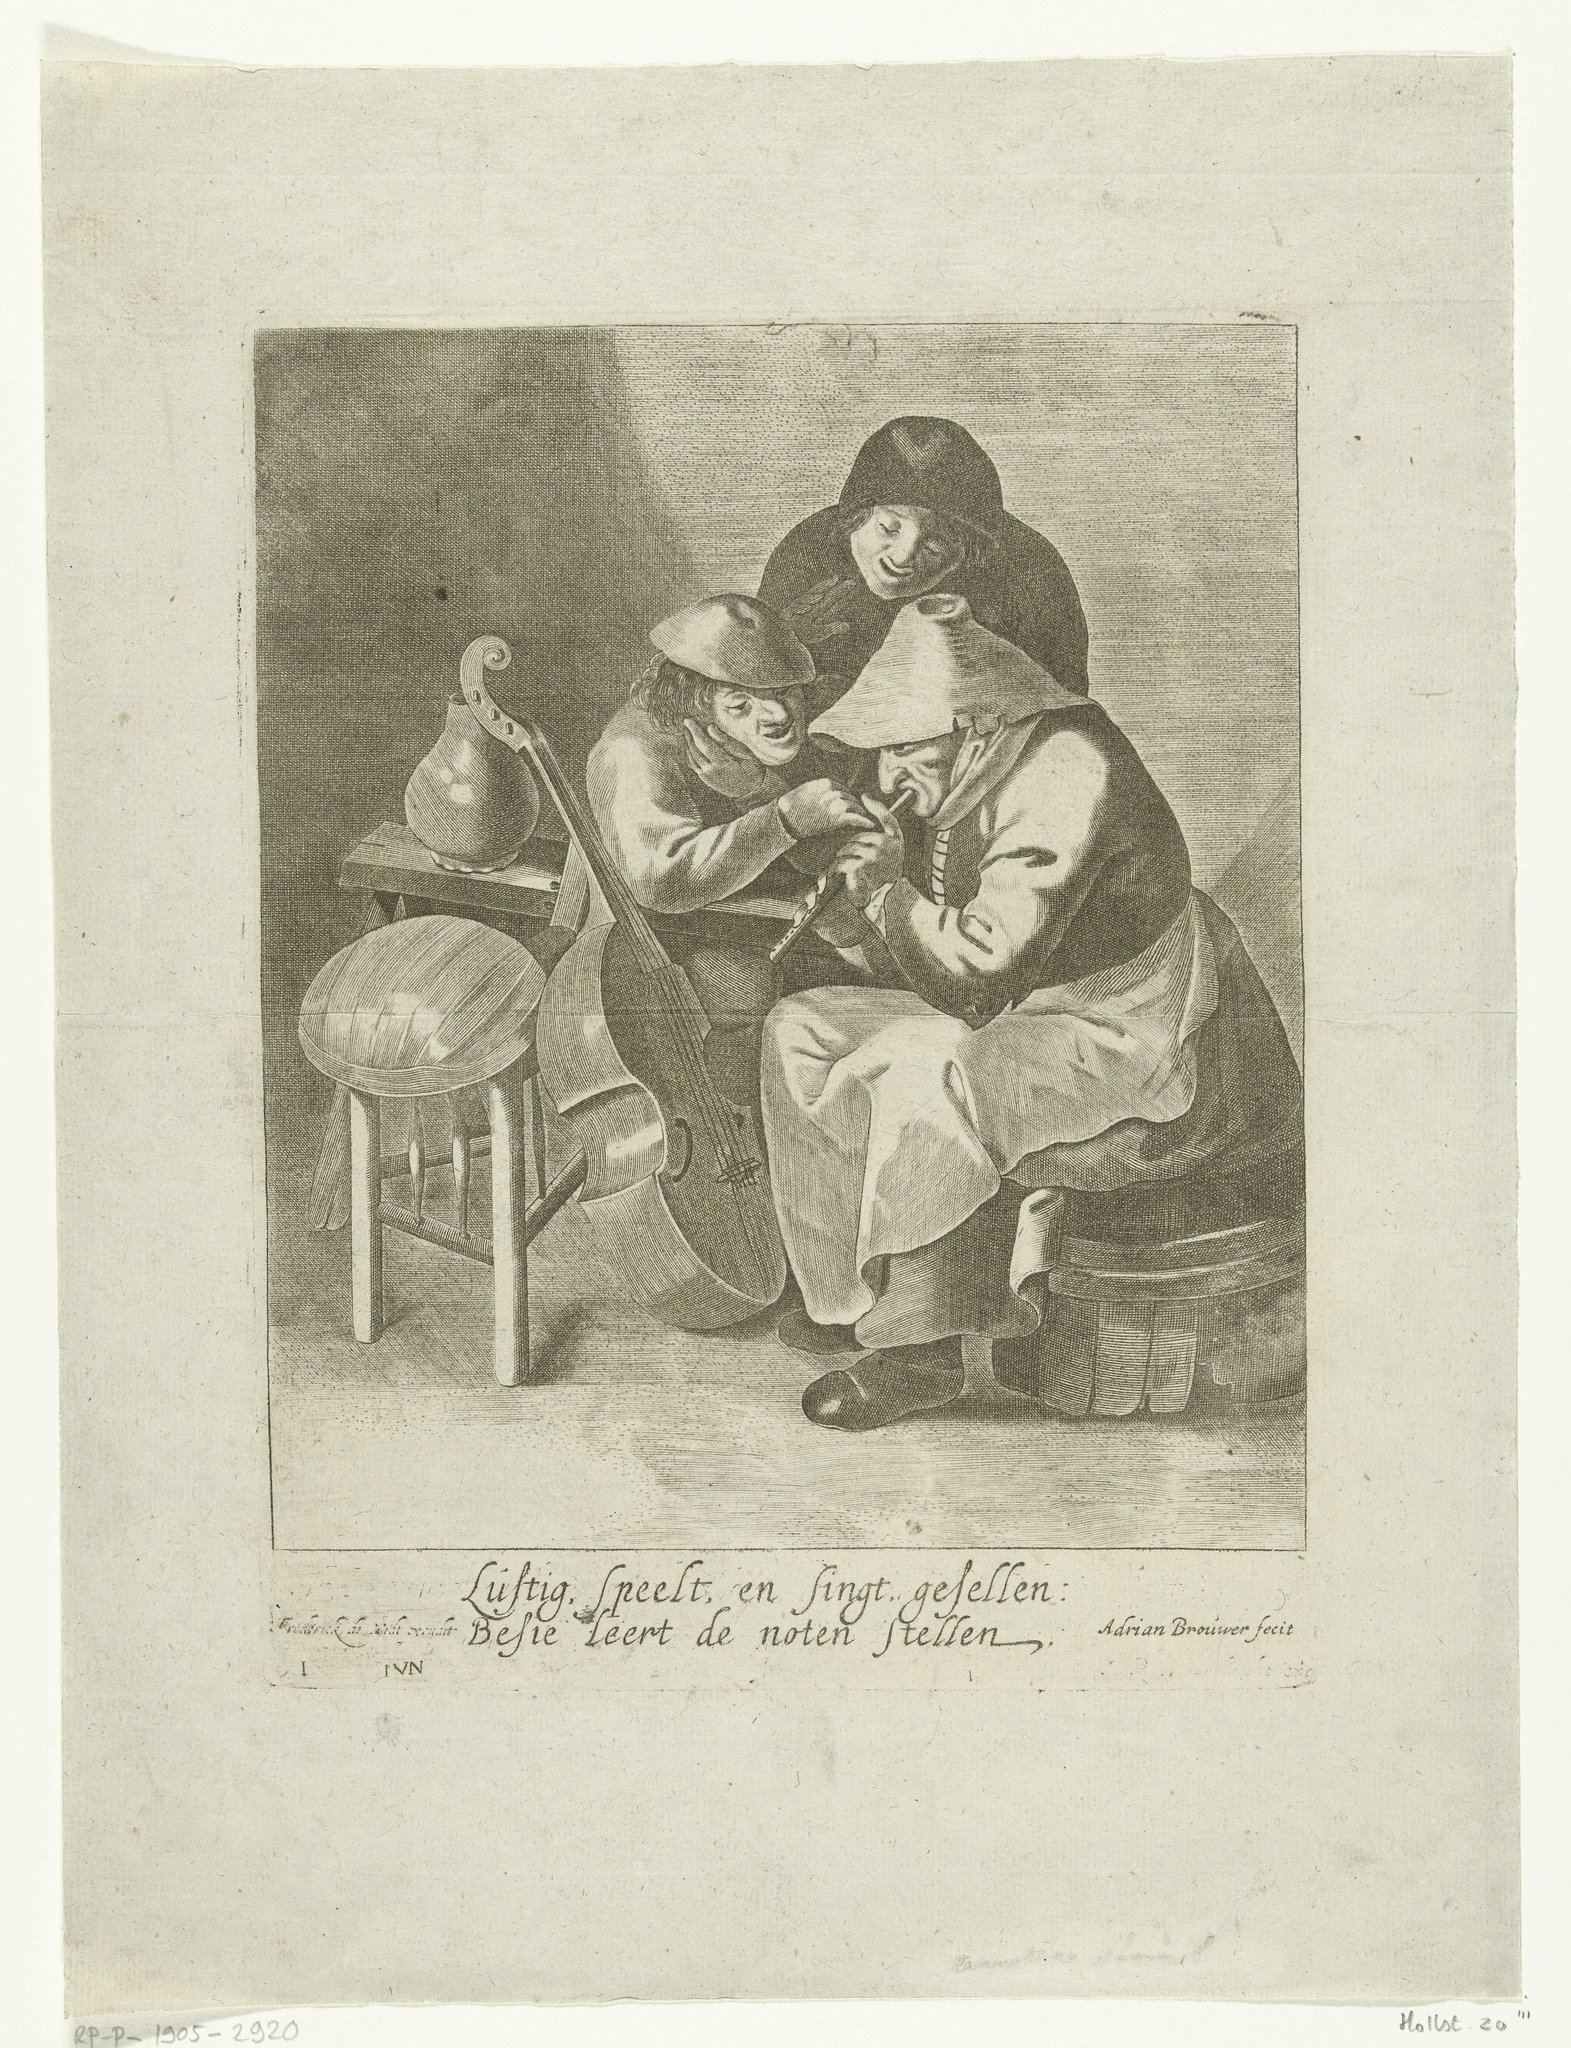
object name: print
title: Interieur van een boerderij met twee boeren en een boerin die fluit speelt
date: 1645-1706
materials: paper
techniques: engraving, etching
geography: amsterdam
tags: farmers, more than one musician with instrument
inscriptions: collector's mark: Lugt 2228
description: Aan een tafel in een boerderij zitten twee mannen en een oude vrouw. Een van de mannen leert de vrouw fluit spelen. Op een stoel ligt een luit en tegen de tafel leunt een gamba. Onder de voorstelling een Nederlands vers.